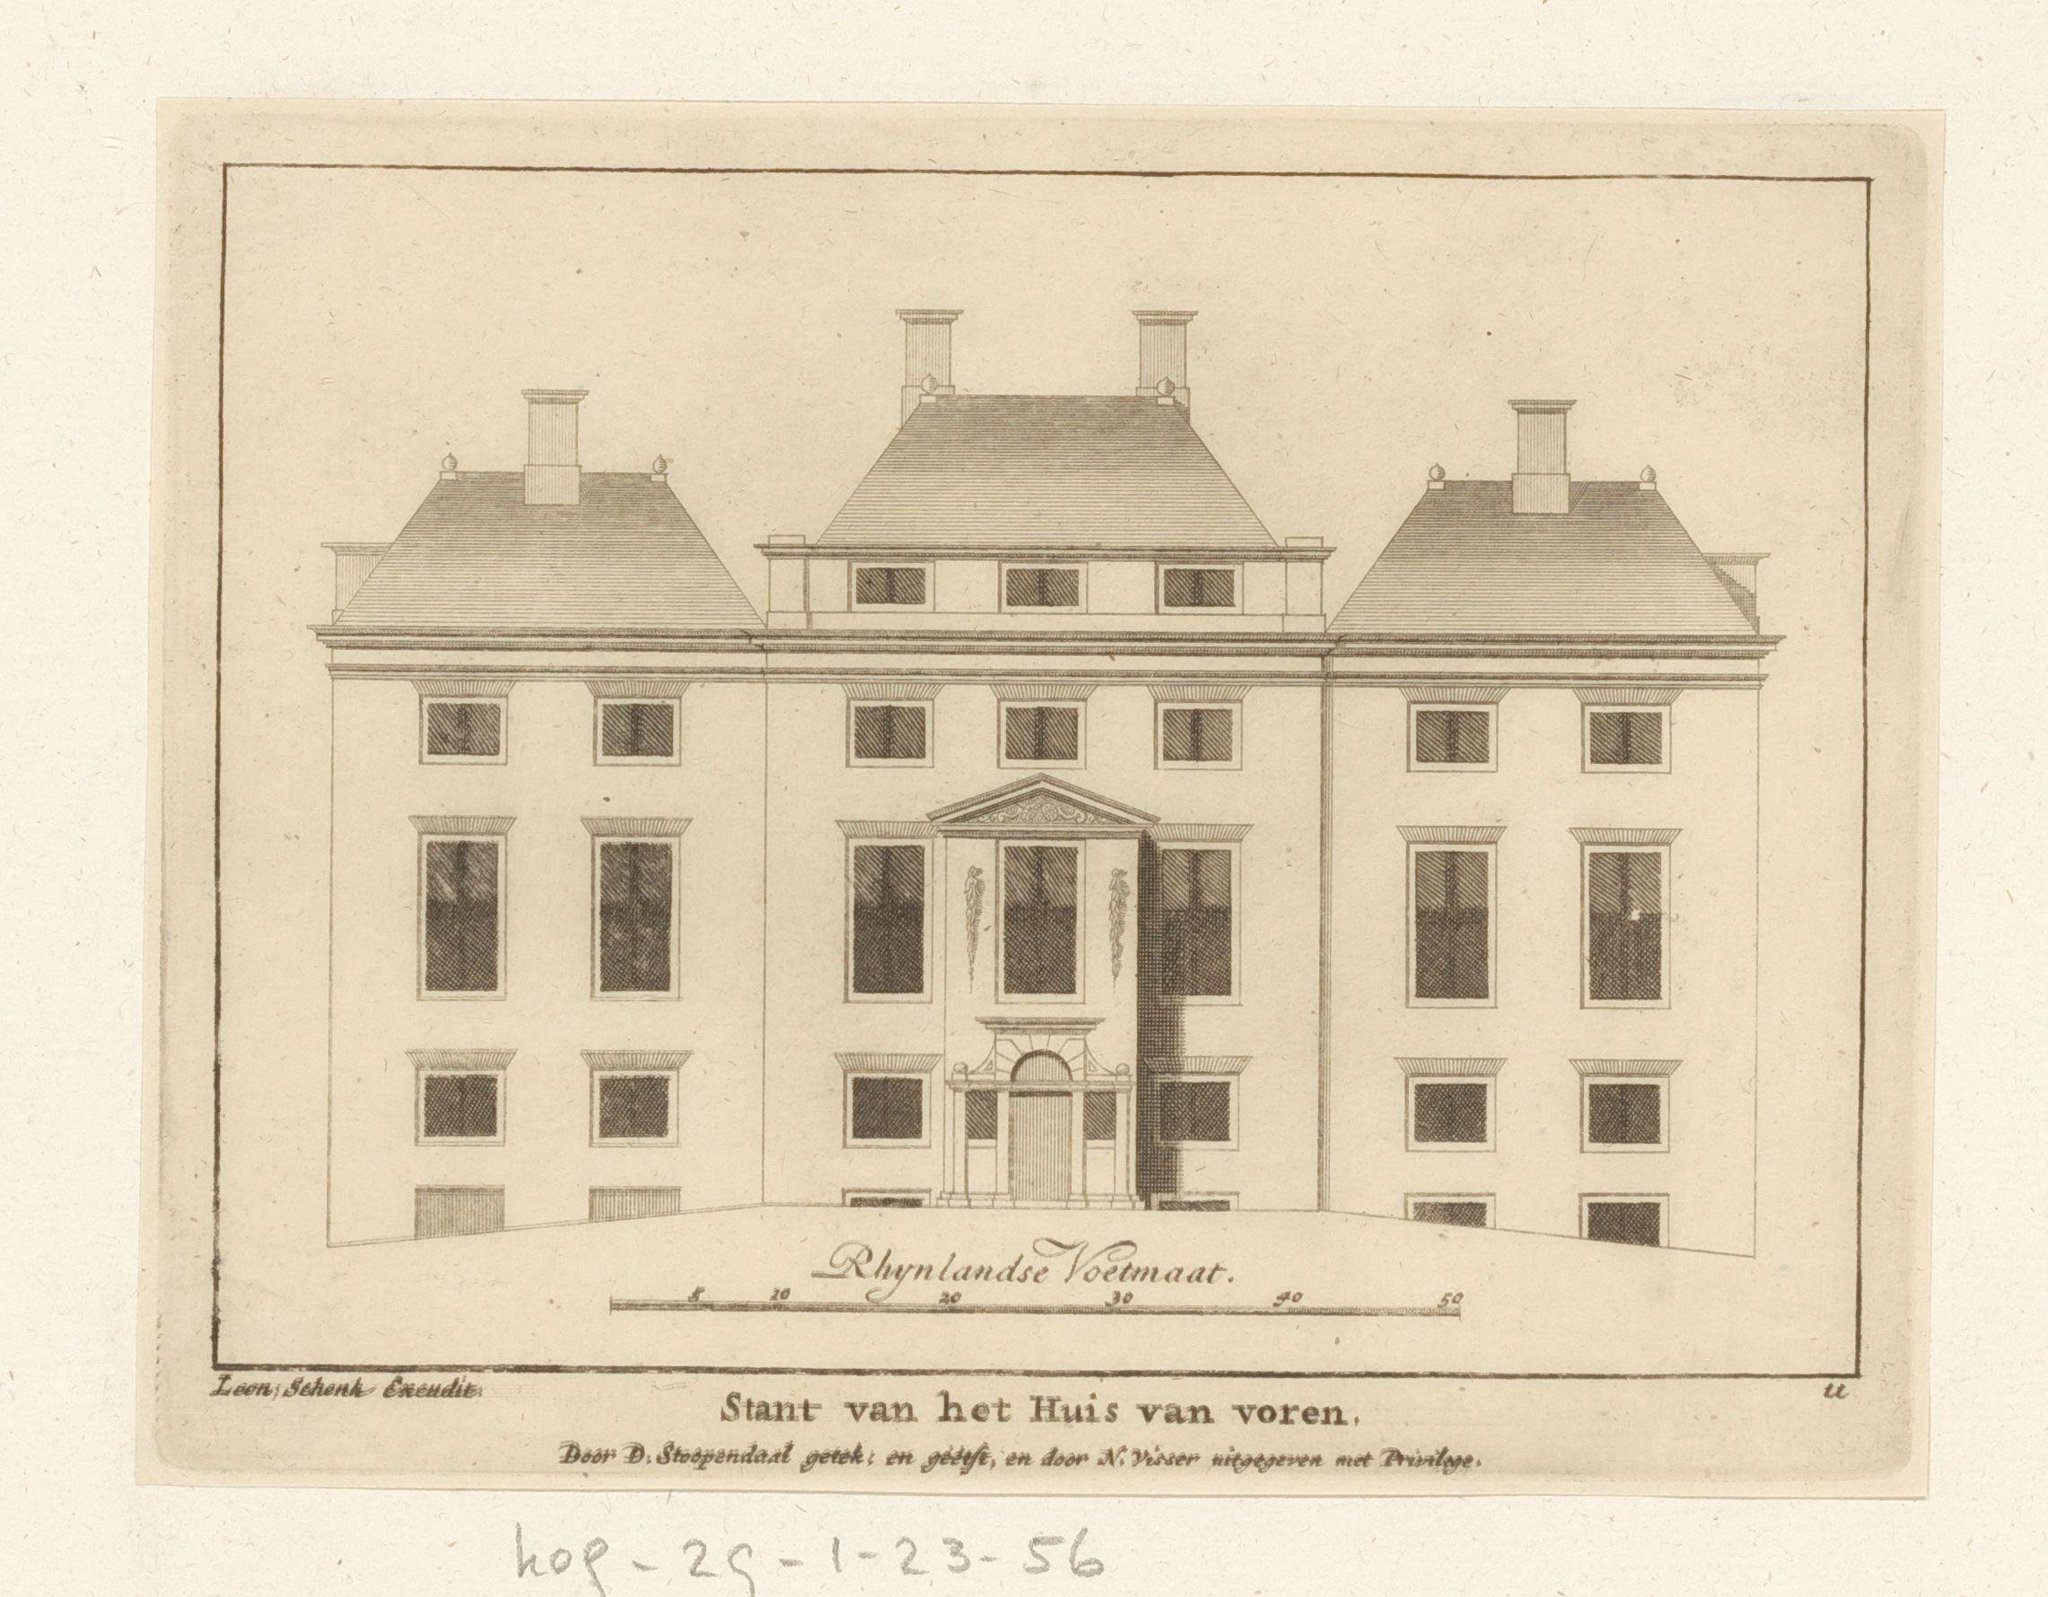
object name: print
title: Stant van het Huis van voren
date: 1706-1767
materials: paper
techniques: engraving, etching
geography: amsterdam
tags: plan ~ architecture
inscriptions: stamp, stamp, collector's mark: Lugt 1641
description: De voorgevel van Huis Clingendael te Den Haag. Onderaan een schaalverdeling. Onderwerpsrubrieken binnen de Atlas Zeden en Gewoonten: Zeden en Gewoonten in Engeren Zin, De Woning. Kastelen en buitenplaatsen. Holland.